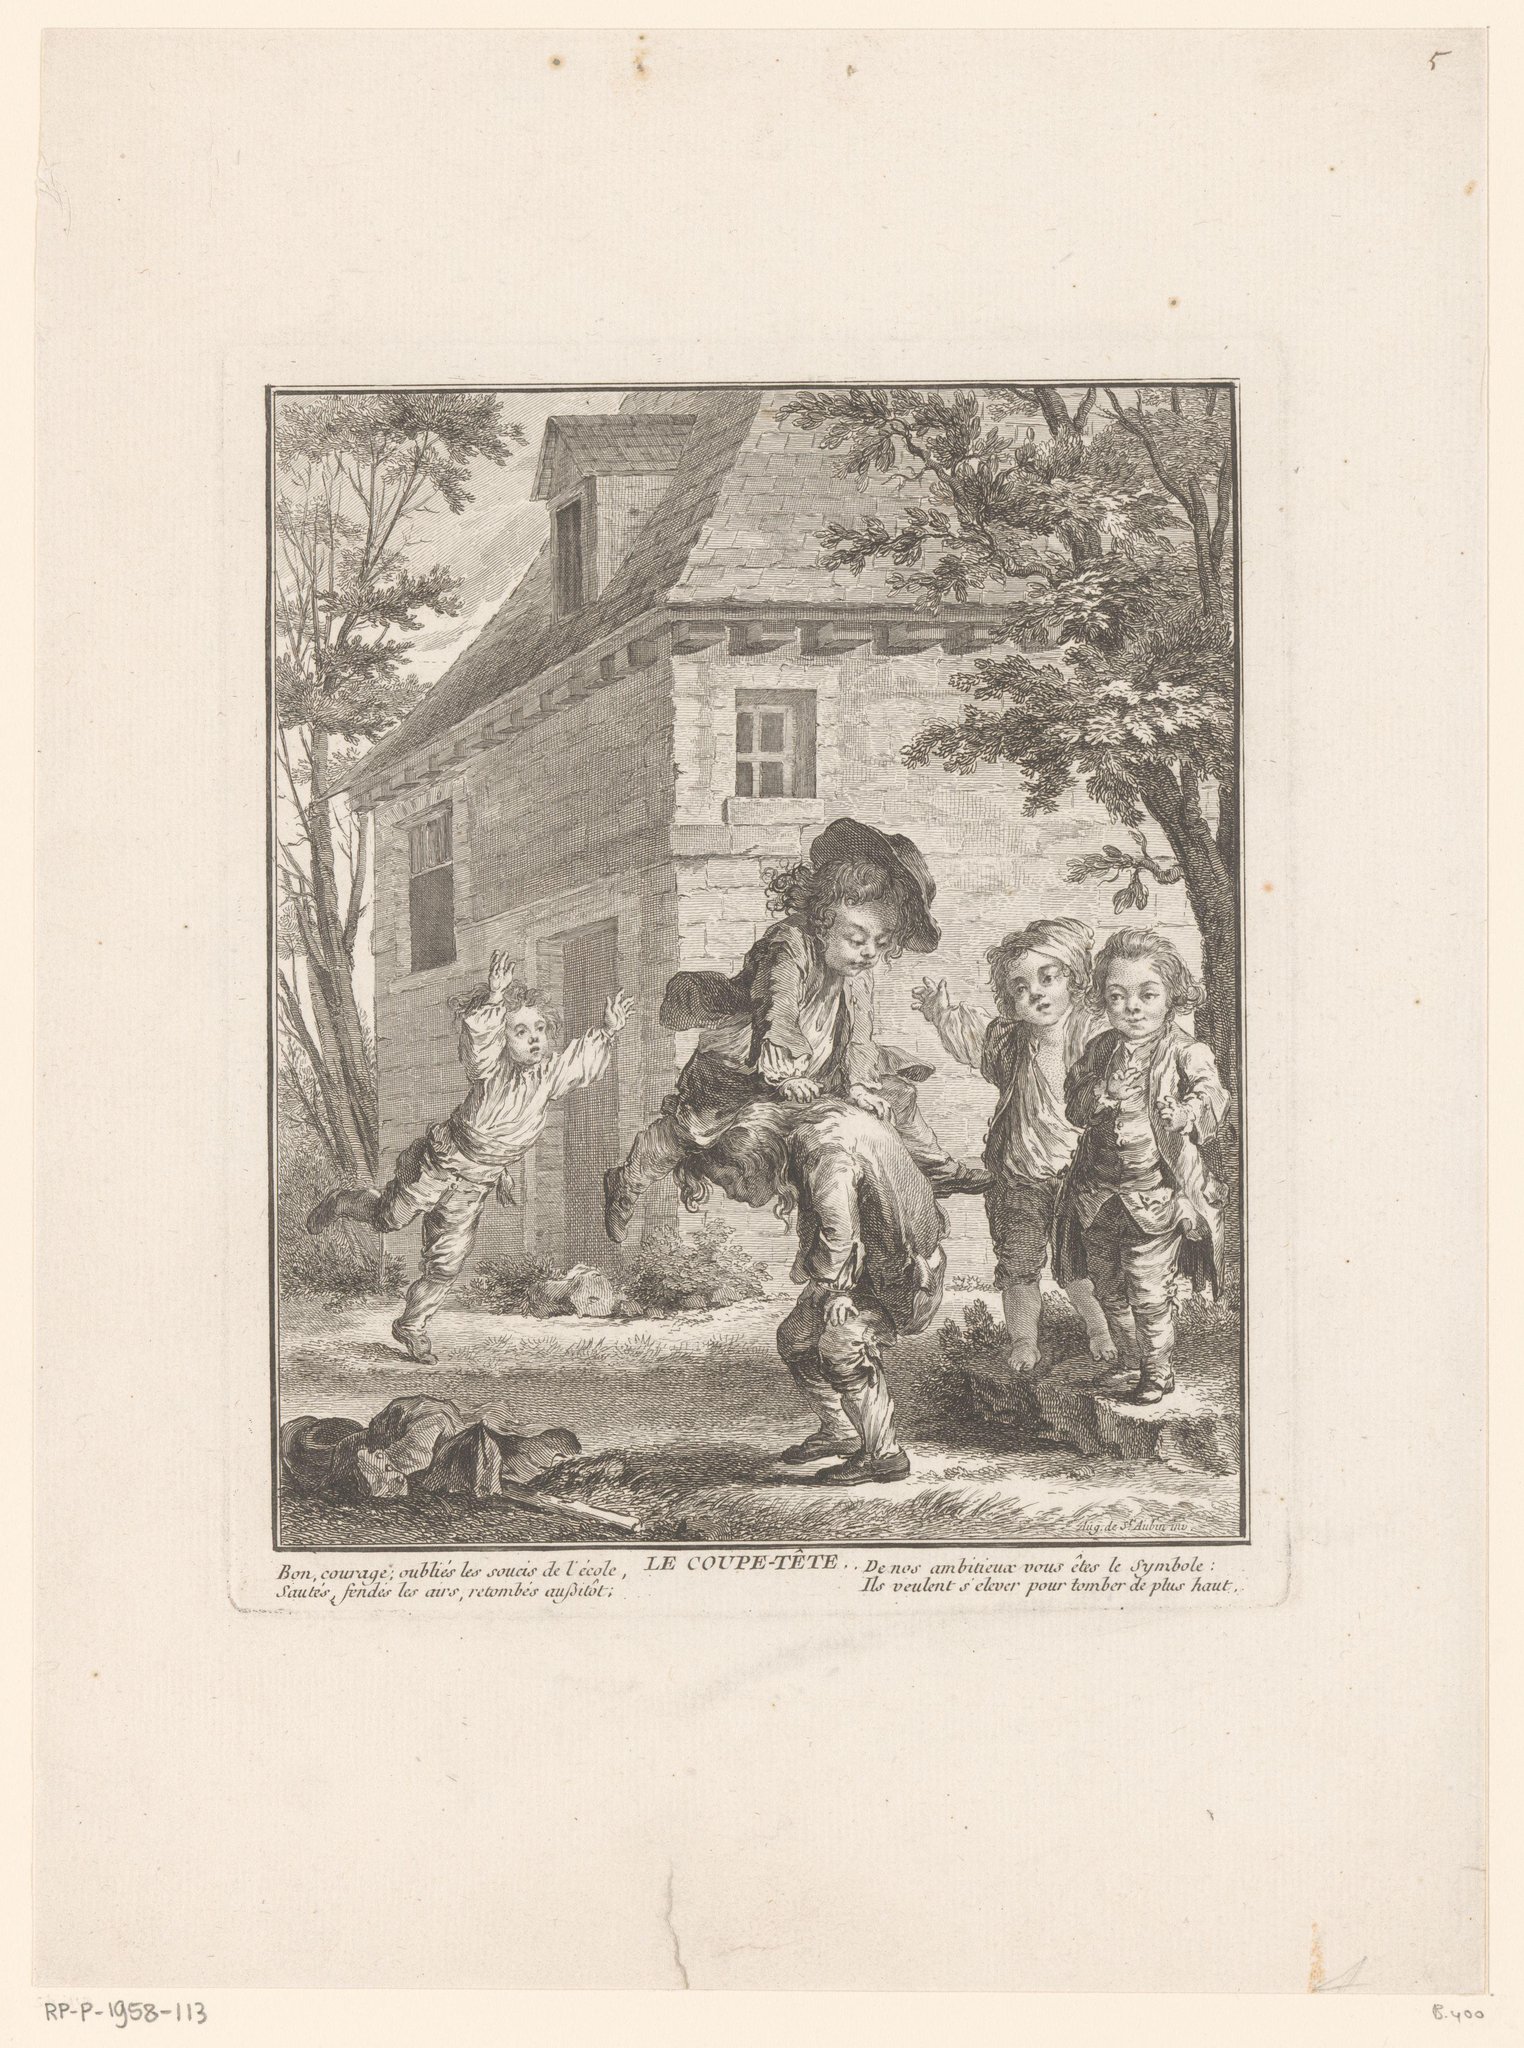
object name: print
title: Kinderen spelen haasje-over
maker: augustin de saint-aubin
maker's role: draughtsman, print maker, publisher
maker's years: 1736-1807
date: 1770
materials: paper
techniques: engraving, etching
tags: leap-frog and variants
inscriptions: collector's mark: Lugt 2760, collector's mark: Lugt 2228, collector's mark: Lugt 533b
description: Prent maakt deel uit van een ongenummerde serie van zes prenten.